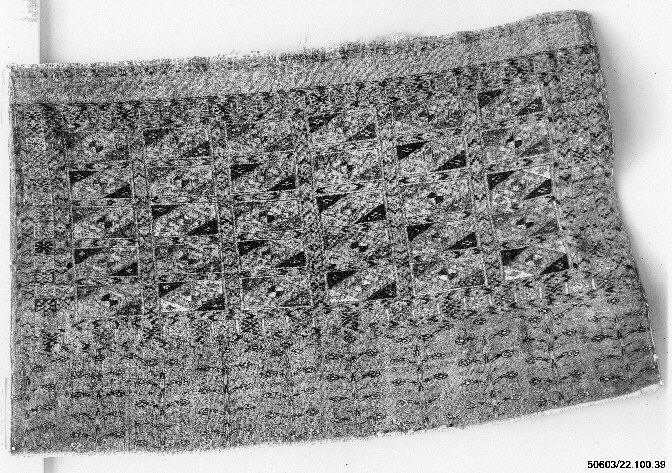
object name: storage bag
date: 1801-1833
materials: silk, wool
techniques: asymmetrically knotted pile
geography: turkmenistan